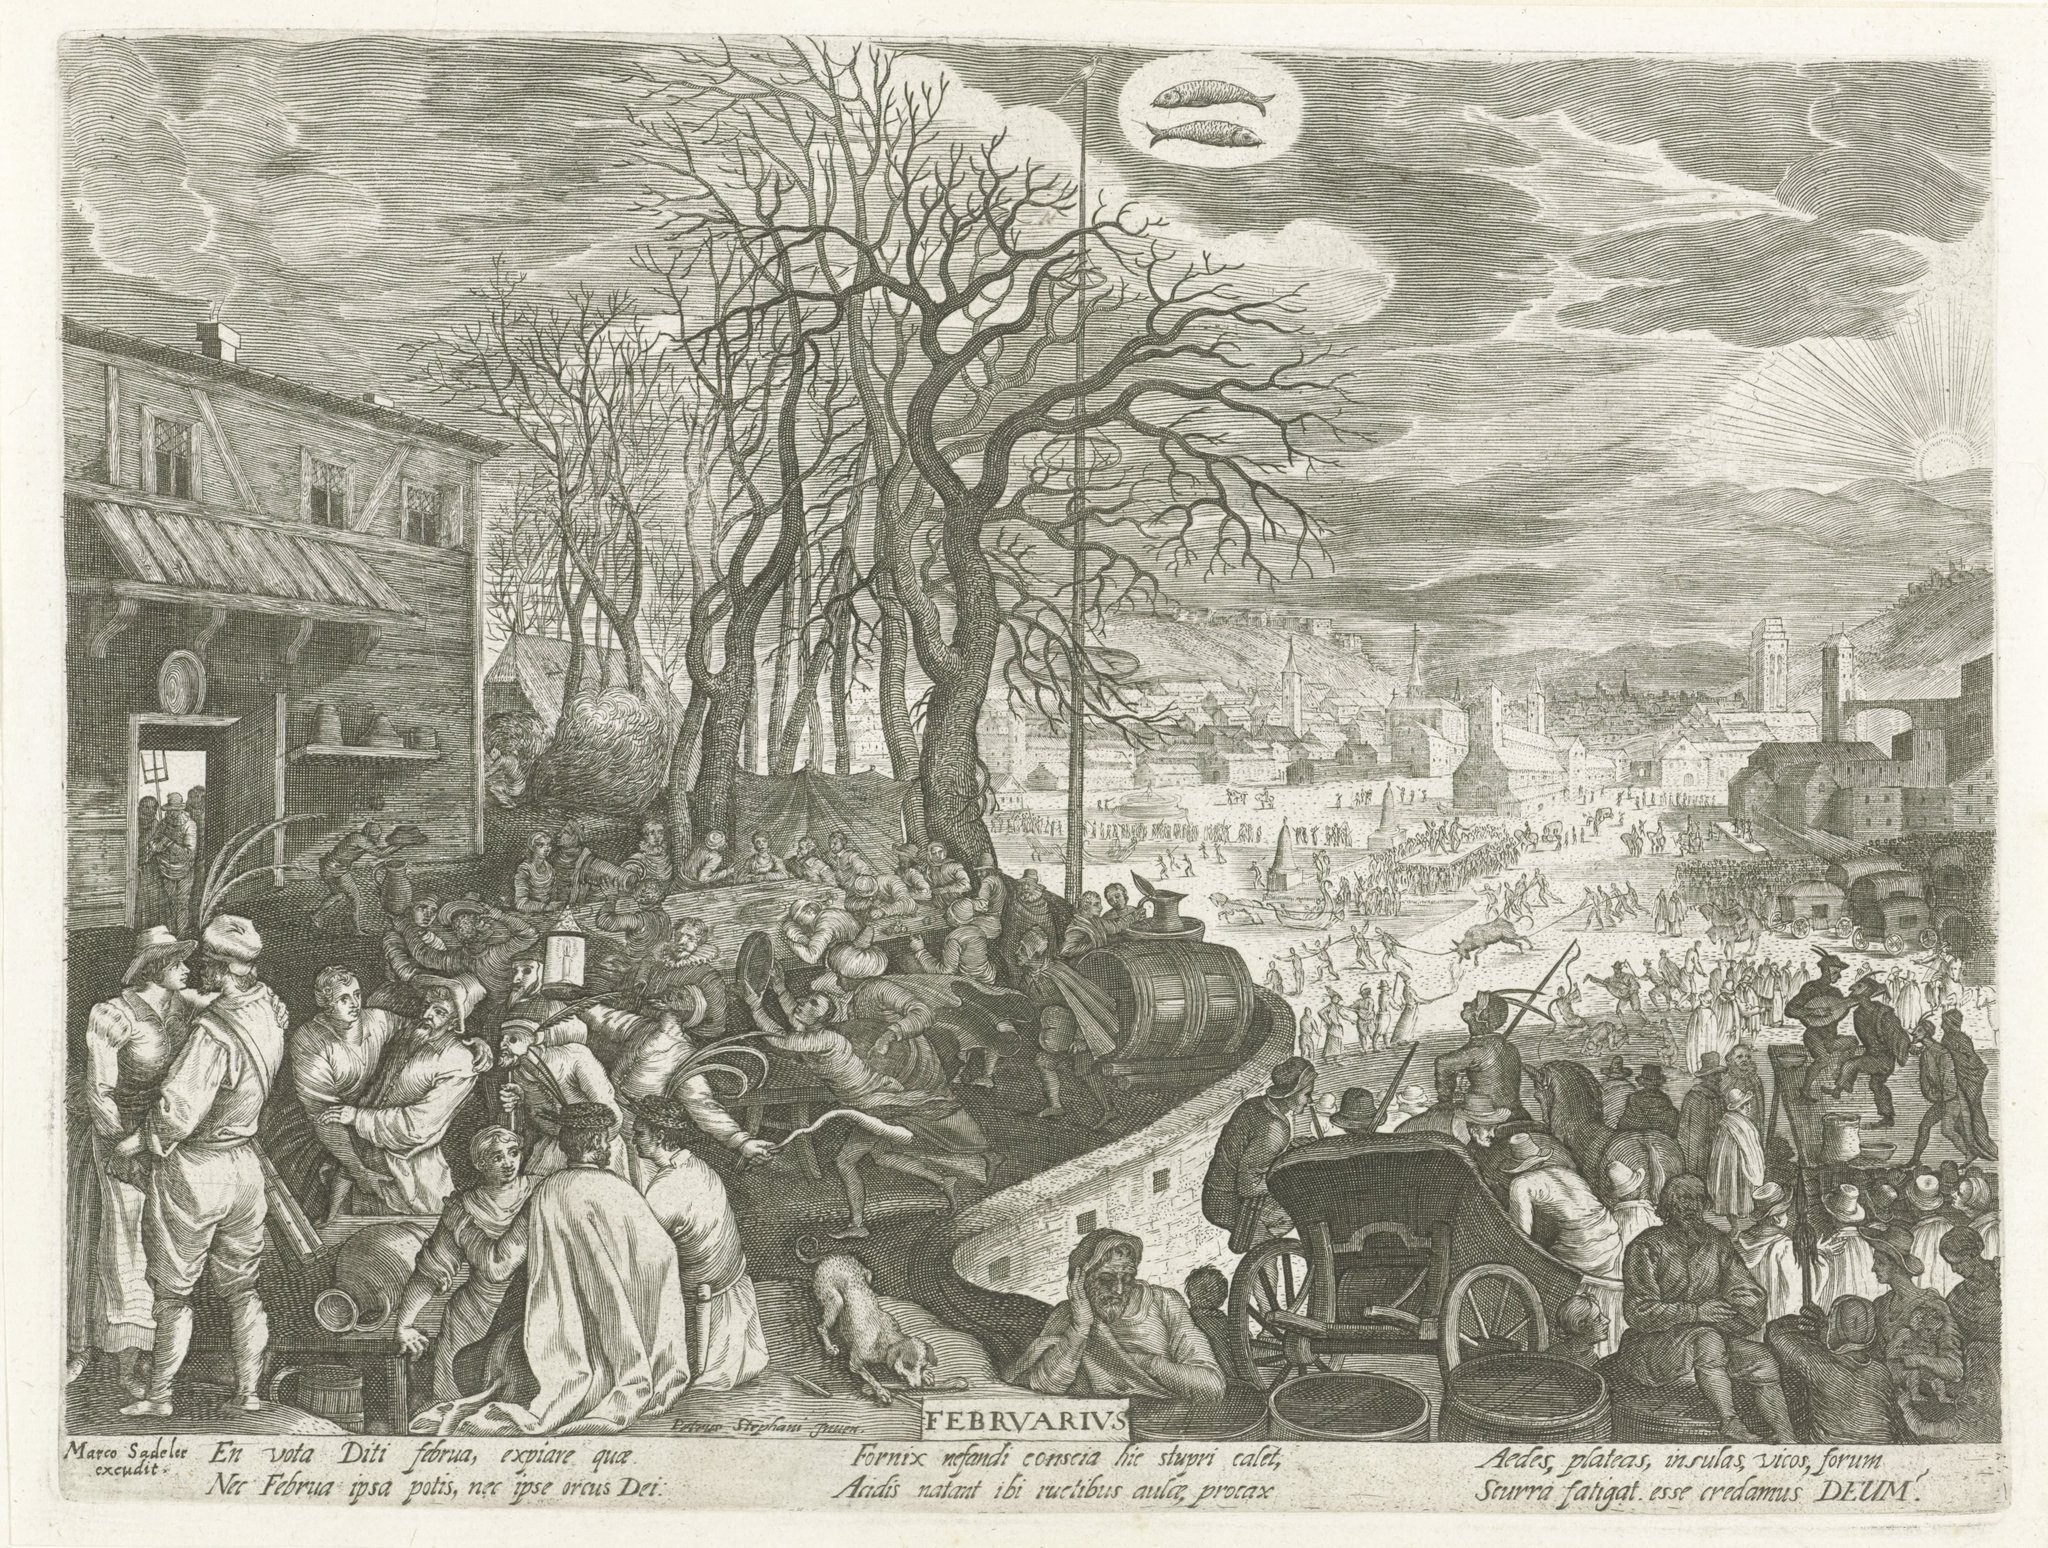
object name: print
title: Febrvarivs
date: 1607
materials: paper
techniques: engraving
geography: venice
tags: mask, group of actors, troupe; actors on the stage, shrove tuesday, 'mardi gras' ~ non-liturgical celebrations of carnival, february and its 'labours' (+ with zodiacal signs)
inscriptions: collector's mark: Lugt 240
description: Links op de voorgrond, voor een taverne, een carnaval vierend gezelschap: er wordt gegeten, gedronken en gevreëen. Middenvoor een rijtuig. Rechts een toneeltje met gemaskerde figuren. Op de achtergrond een gevecht met een stier en gezicht in een dorp. Middenboven het sterrenbeeld Vissen. De prent heeft een Latijns onderschrift.